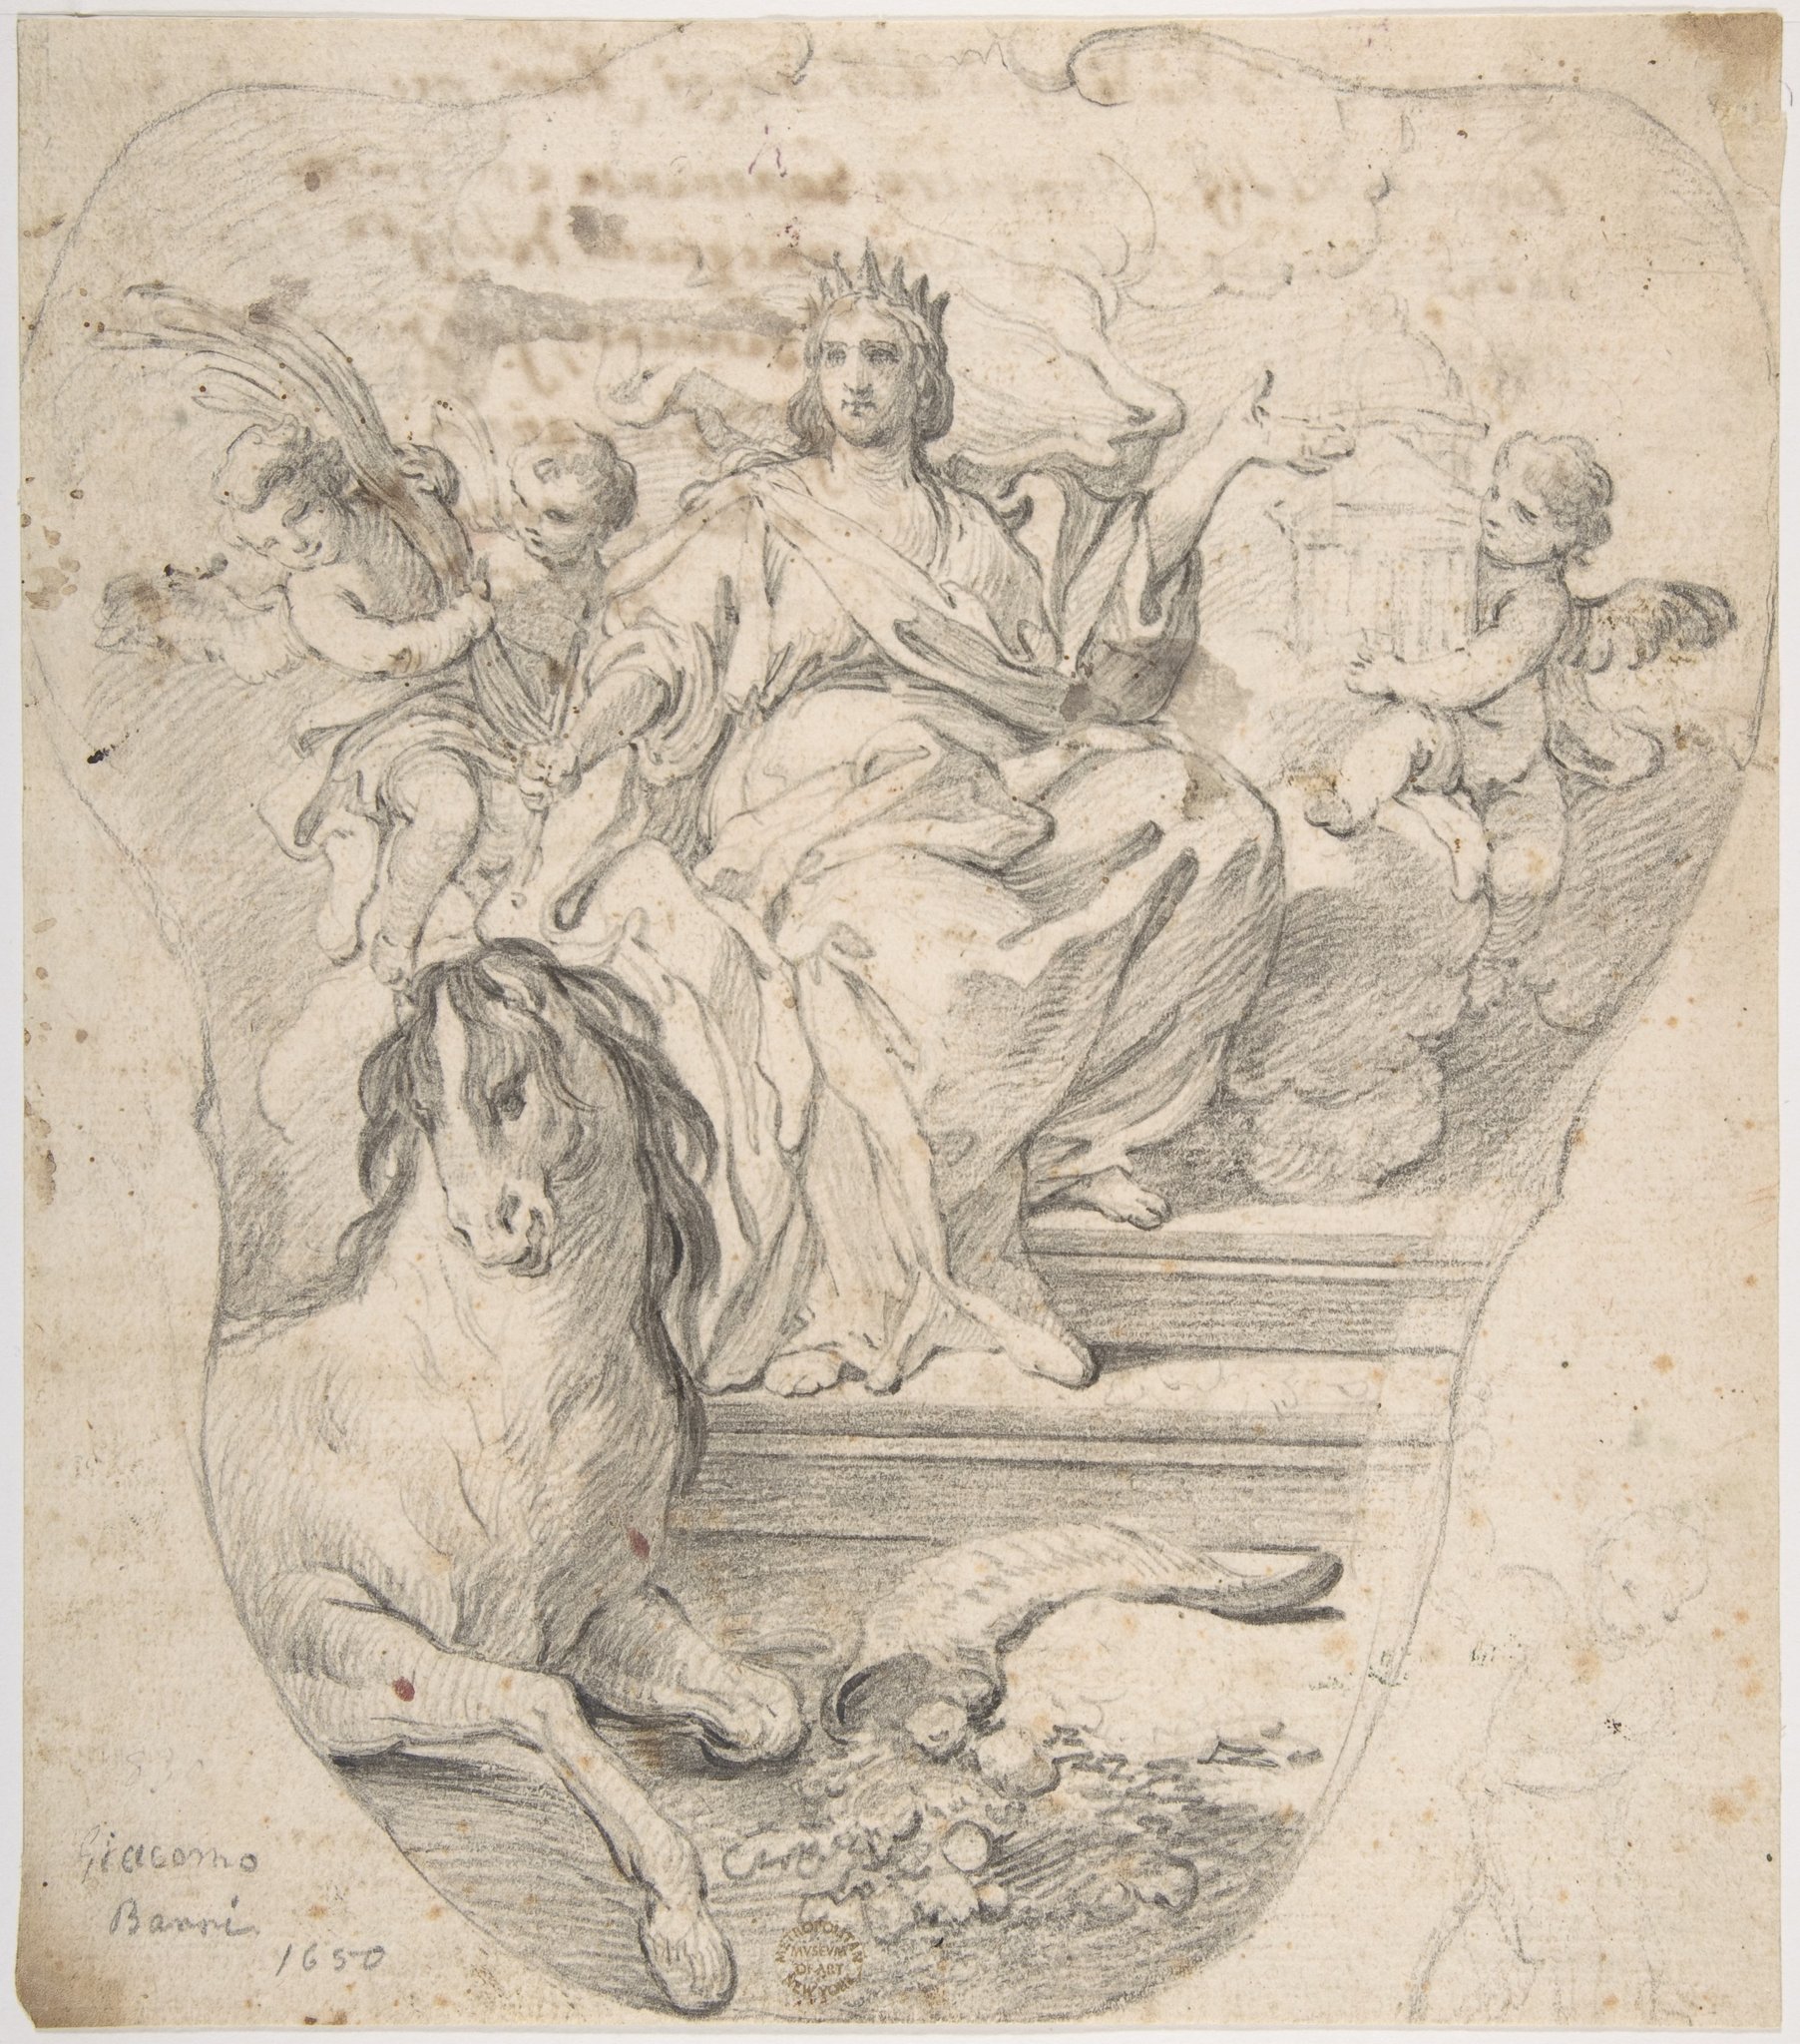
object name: drawing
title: Design for Panel: Allegory of Europe, from "The Four Continents"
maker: giacomo barri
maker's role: artist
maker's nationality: italian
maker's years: 1630-1689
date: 1650-1679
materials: chalk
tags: women,putti,horses